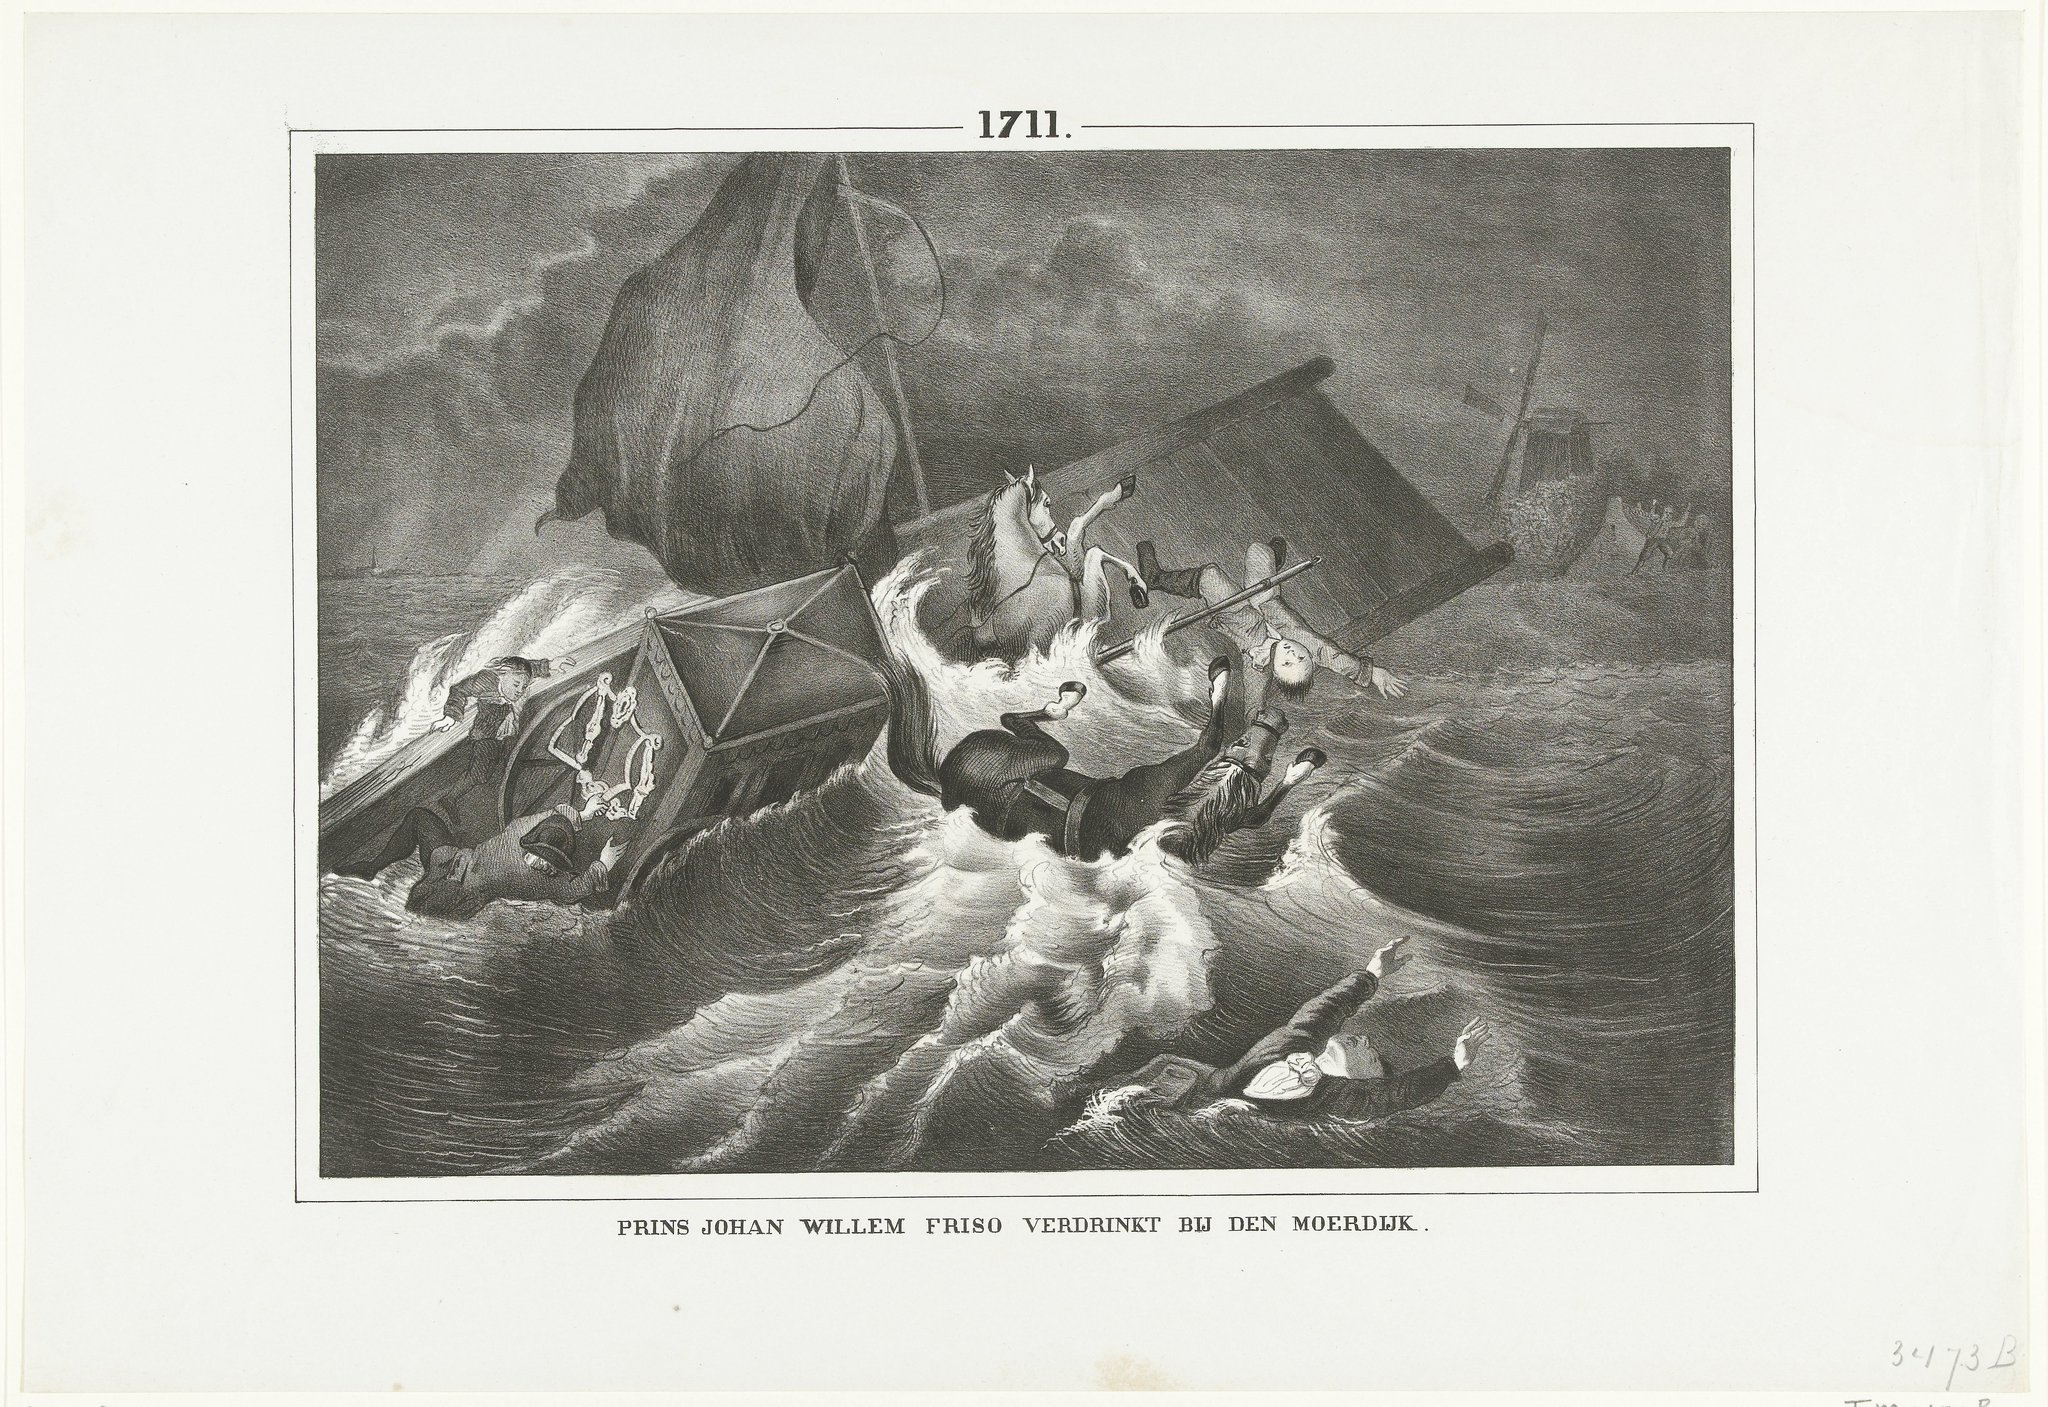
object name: print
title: 1711 / Prins Johan Willem Friso verdrinkt bij den Moerdijk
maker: Anonymous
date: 1853-1855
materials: paper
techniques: lithograph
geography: netherlands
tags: johan willem friso (prins van oranje-nassau), death by drowning (non-violent)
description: Gebruikt als illustratie in: J.H. Eichman & H. Altmann, Vaderlandsche historieplaten voor scholen en huisgezinnen, Leiden, 1855. Dit nummer is een door het RPK toegevoegd nummer en staat niet in Frederik Muller, het werk waar de prent voor is gemaakt of uit afkomstig is, staat wel vermeld in Frederik Muller.